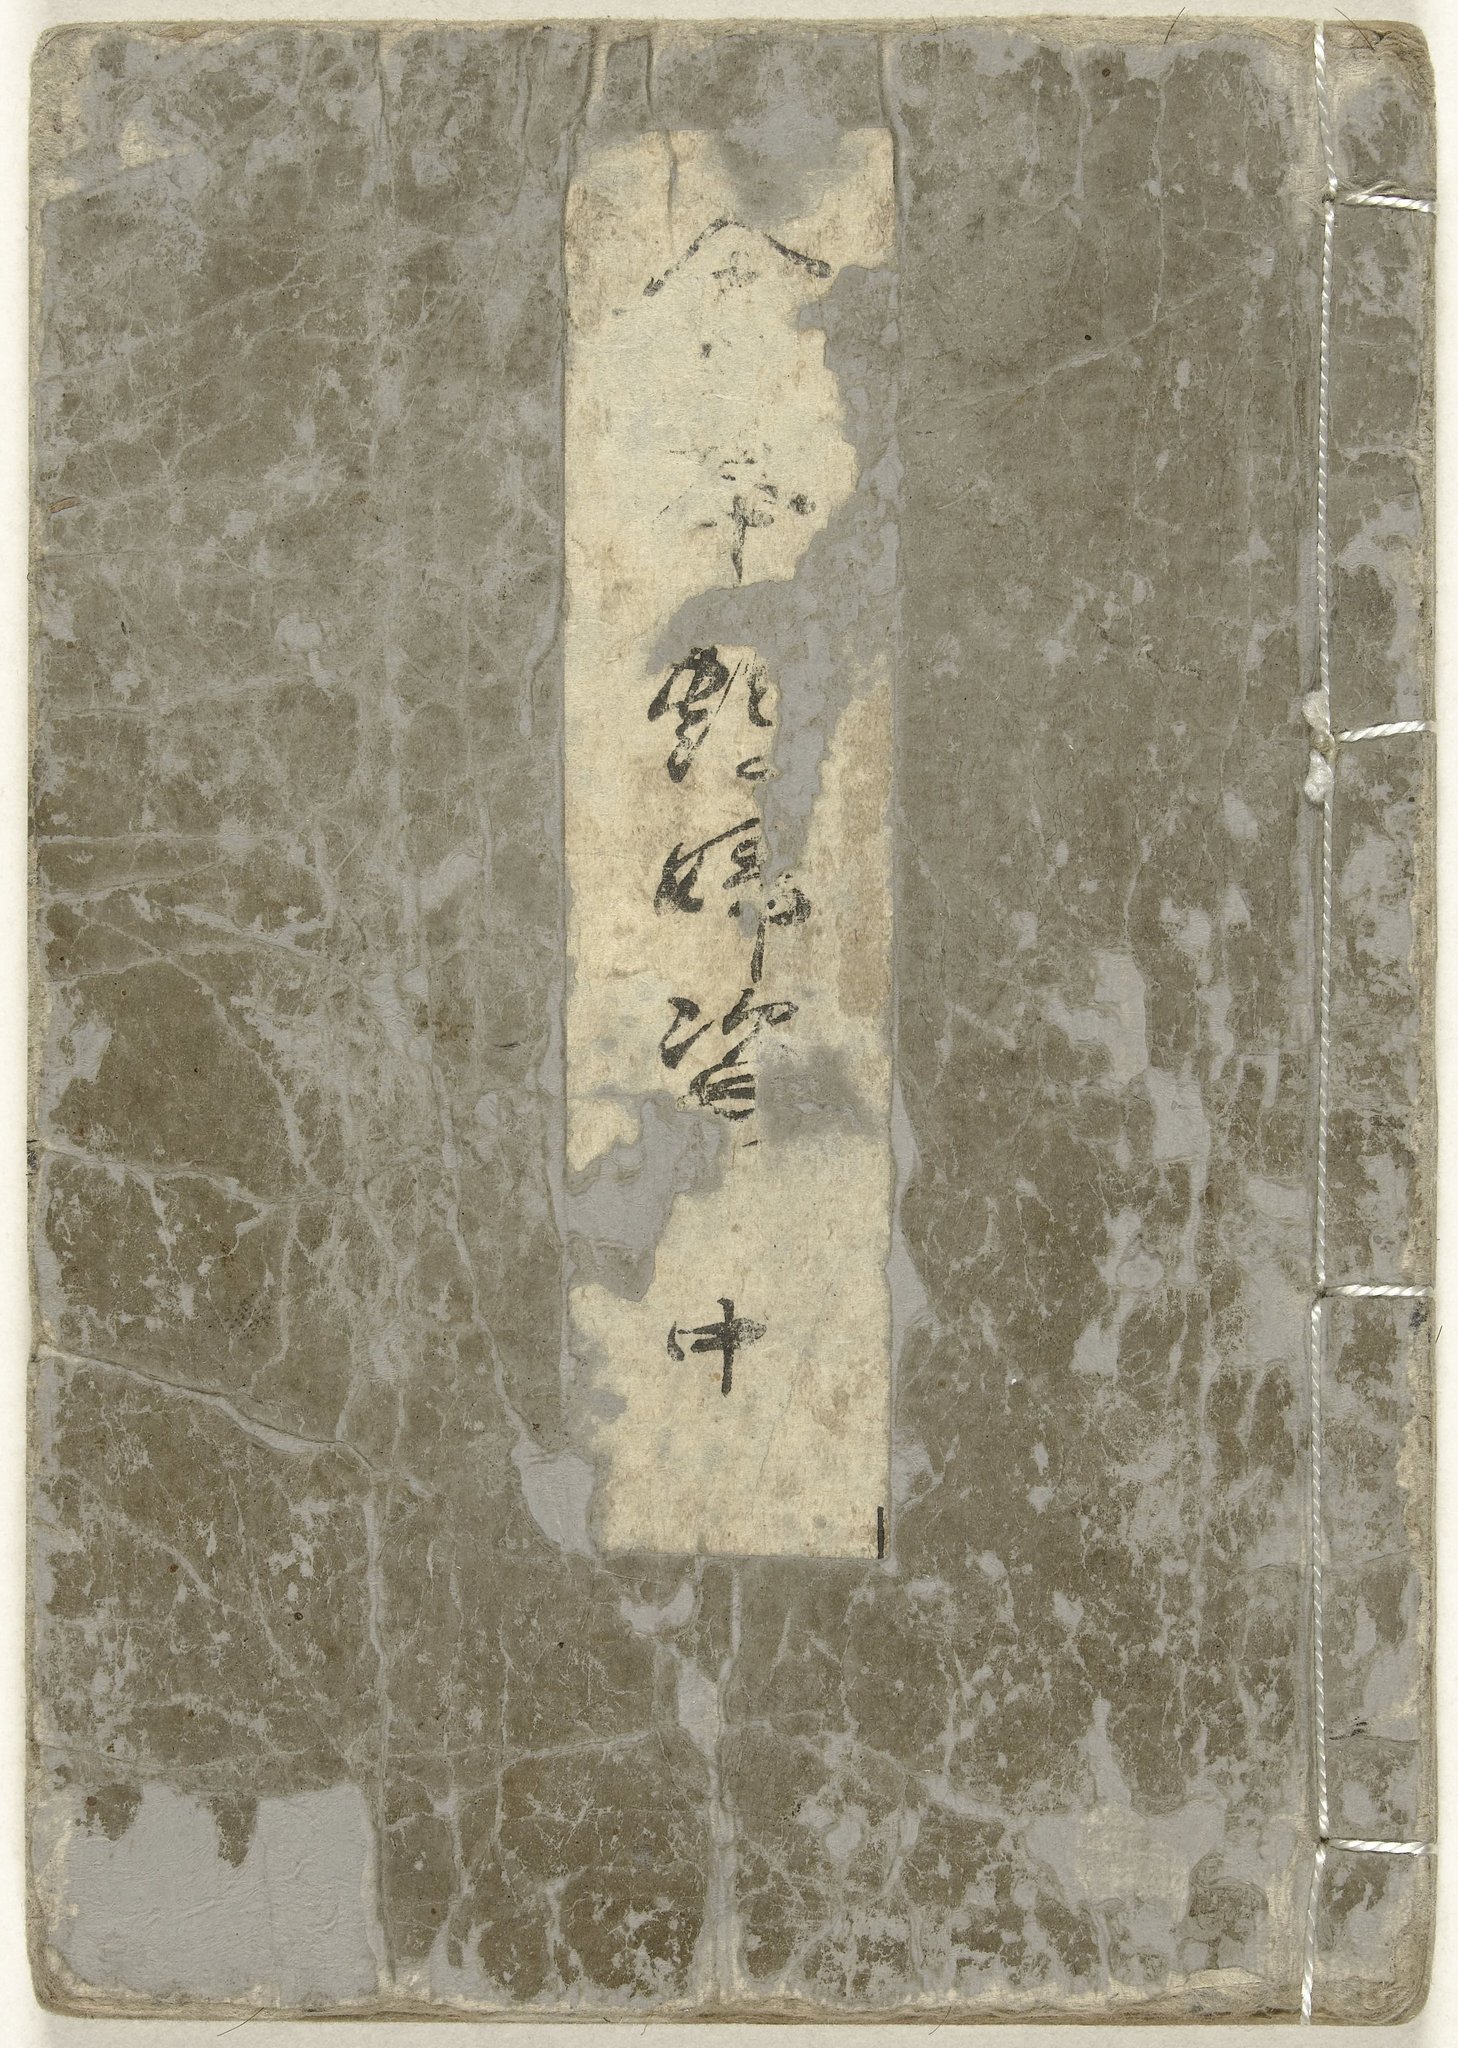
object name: shunga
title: Shunga album. Prentenboek over gewillige vrouwen - deel twee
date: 1798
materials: paper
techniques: woodcut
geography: japan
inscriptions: collector's mark: Lugt 2228